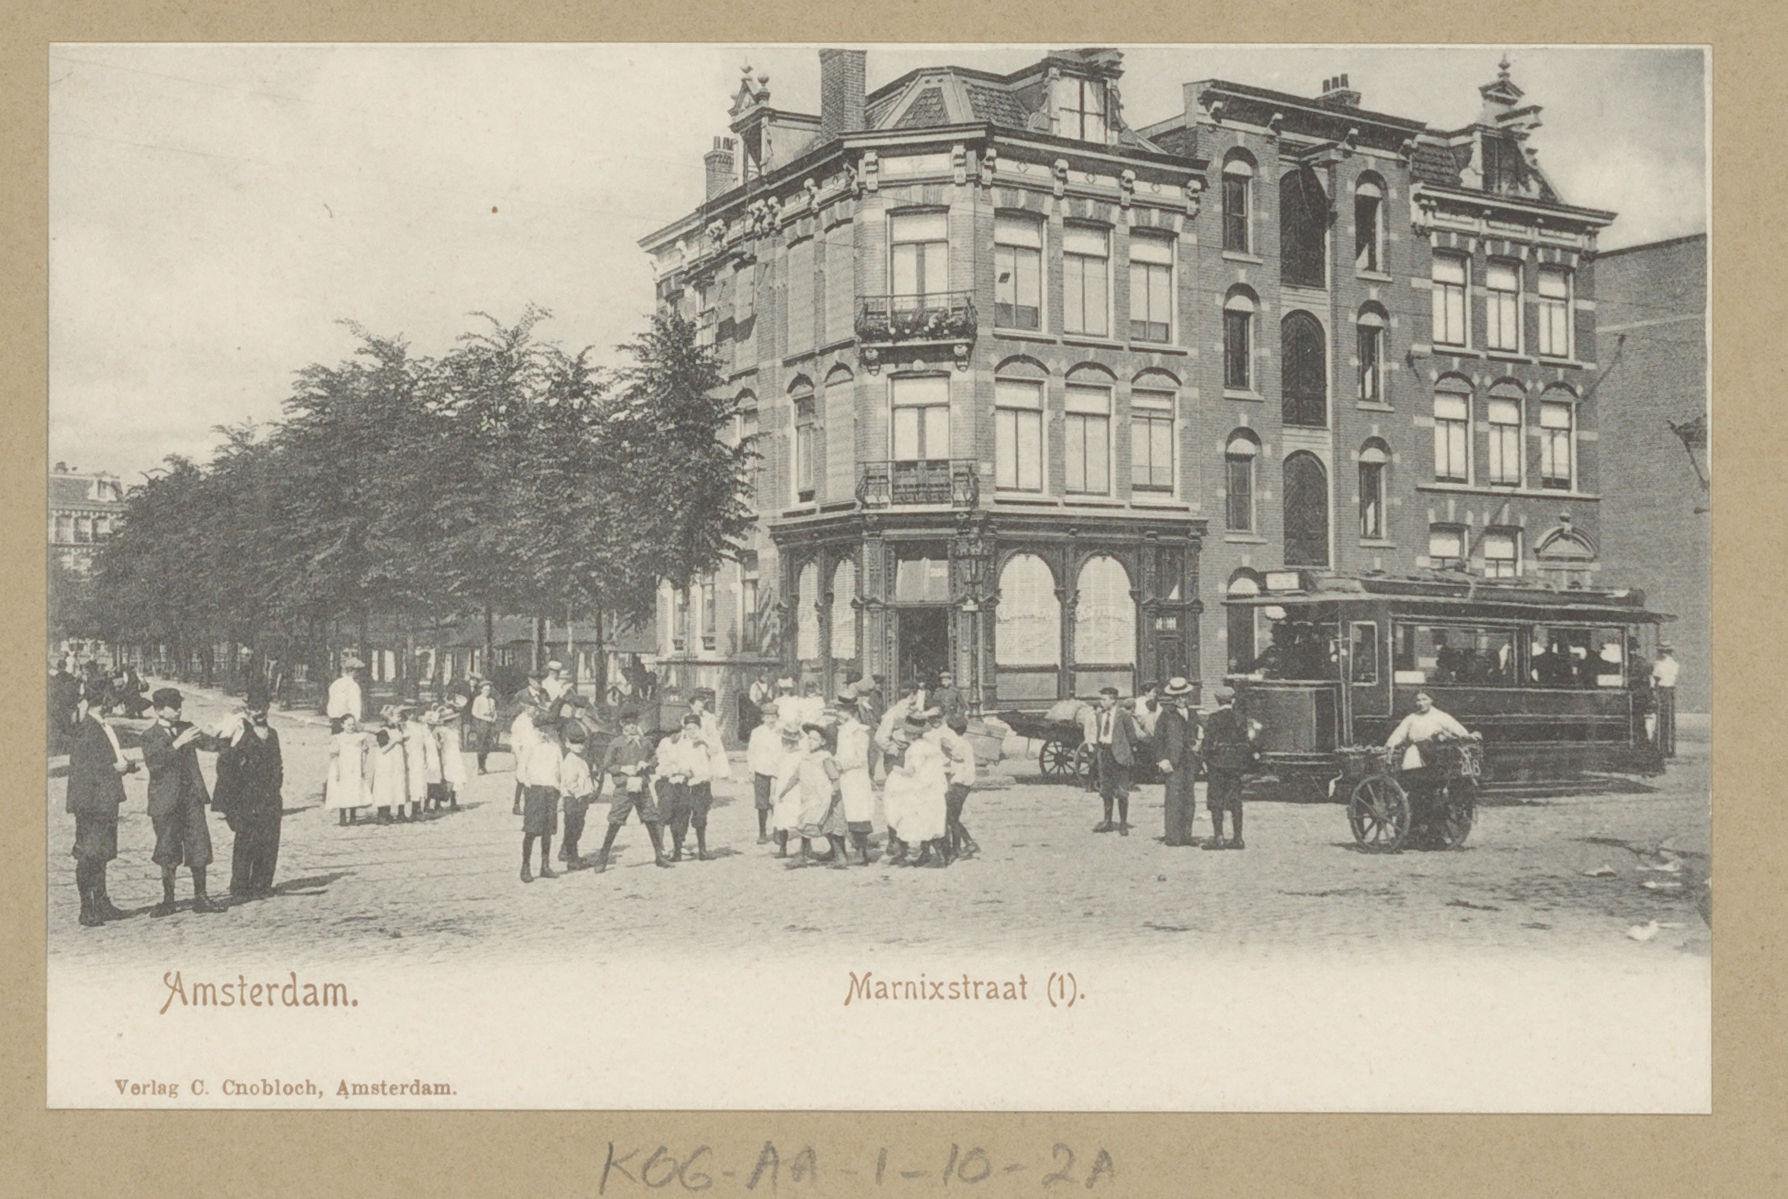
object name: photomechanical print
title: Gezicht op de Marnixstraat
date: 1875-1930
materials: cardboard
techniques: photograph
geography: amsterdam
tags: city-view in general; 'veduta', the usual house or row of houses, street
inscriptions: collector's mark: ‘10,2 A-D’ Lugt 1641b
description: Onderwerpsrubriek binnen de Atlas Amsterdam: Maagdelievenstraat, Markenplein, Marnixstraat, Martelaarsgracht, Meeuwenlaan, Mennonietenpad, Meijerplein (Jonas Daniël), Mozes en Aäronstraat, Muidergracht, Muntplein.